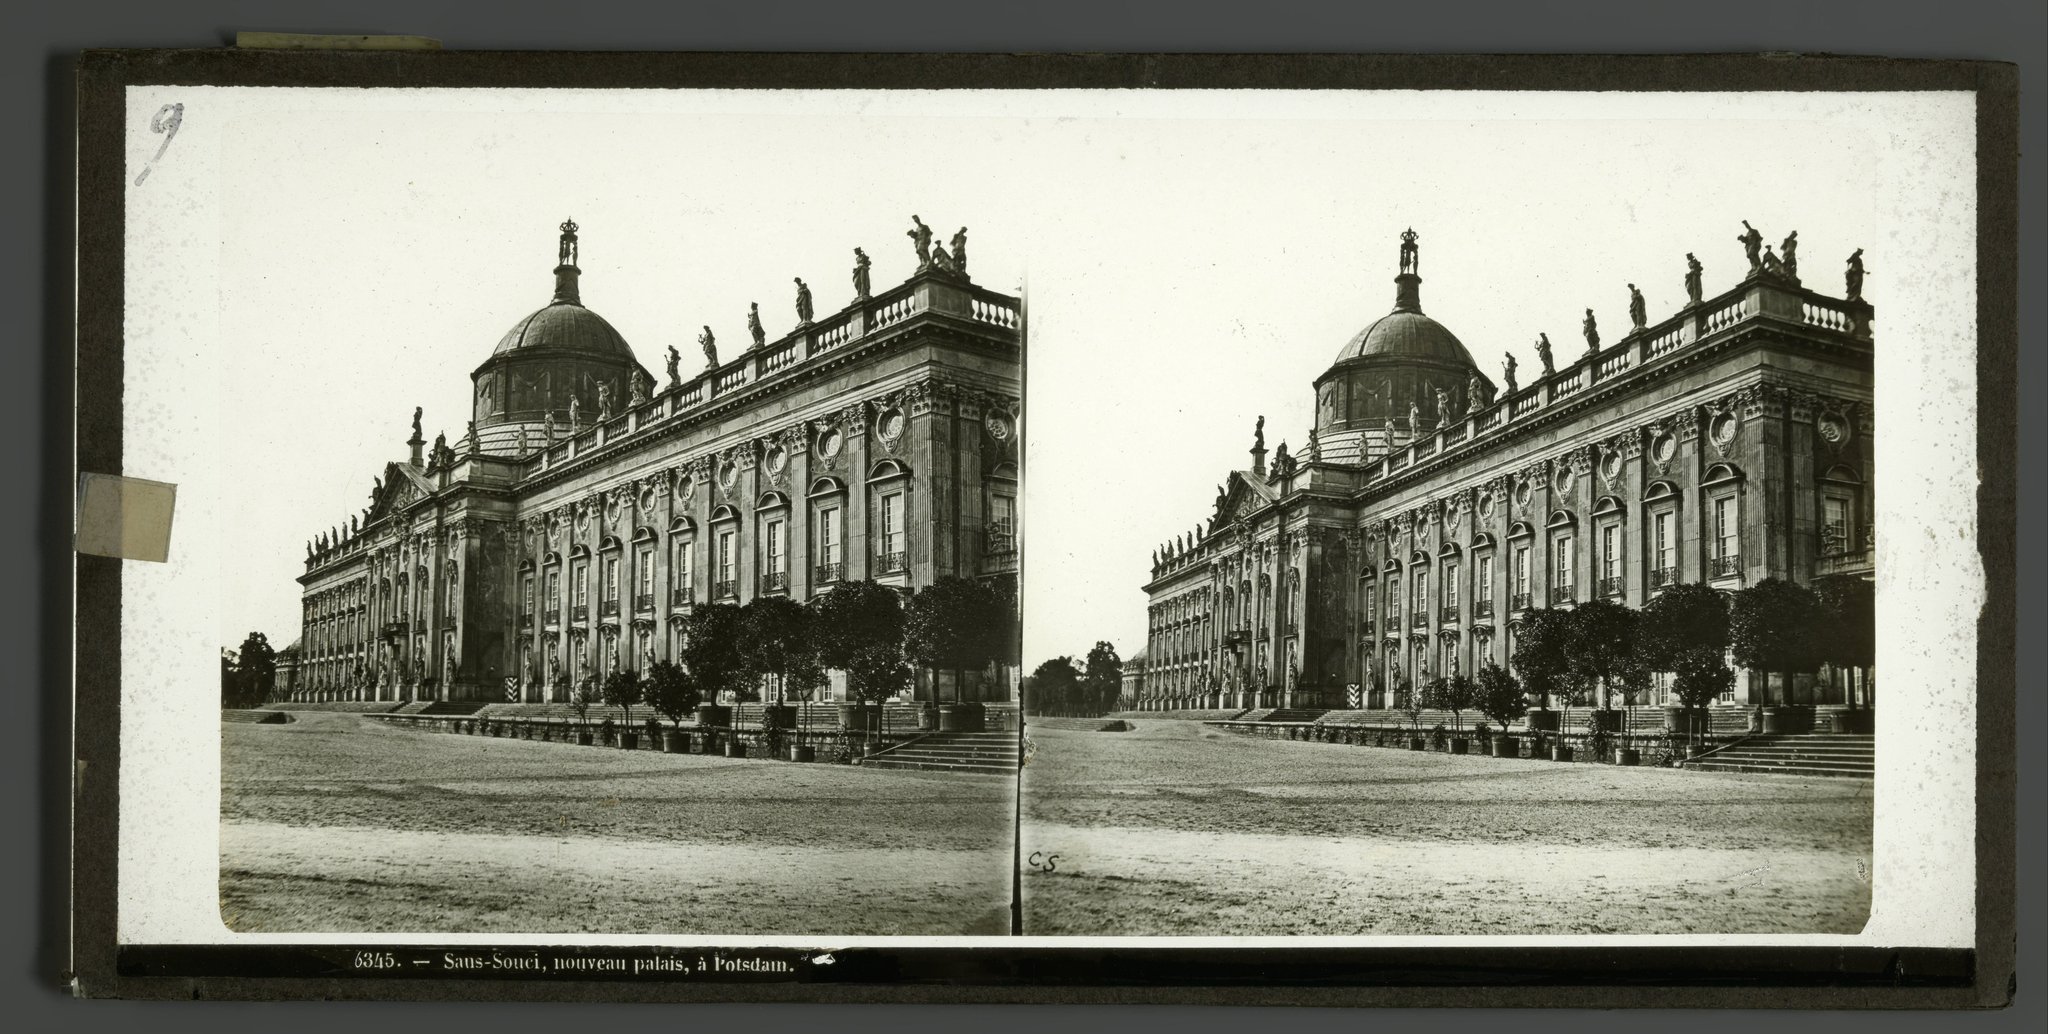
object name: stereoscopic photograph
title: Gezicht op slot Sanssouci te Potsdam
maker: Anonymous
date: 1860-1890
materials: glass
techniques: slide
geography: potsdam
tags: palace, exterior ~ representation of a building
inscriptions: number: ‘6345’, number: ‘9’